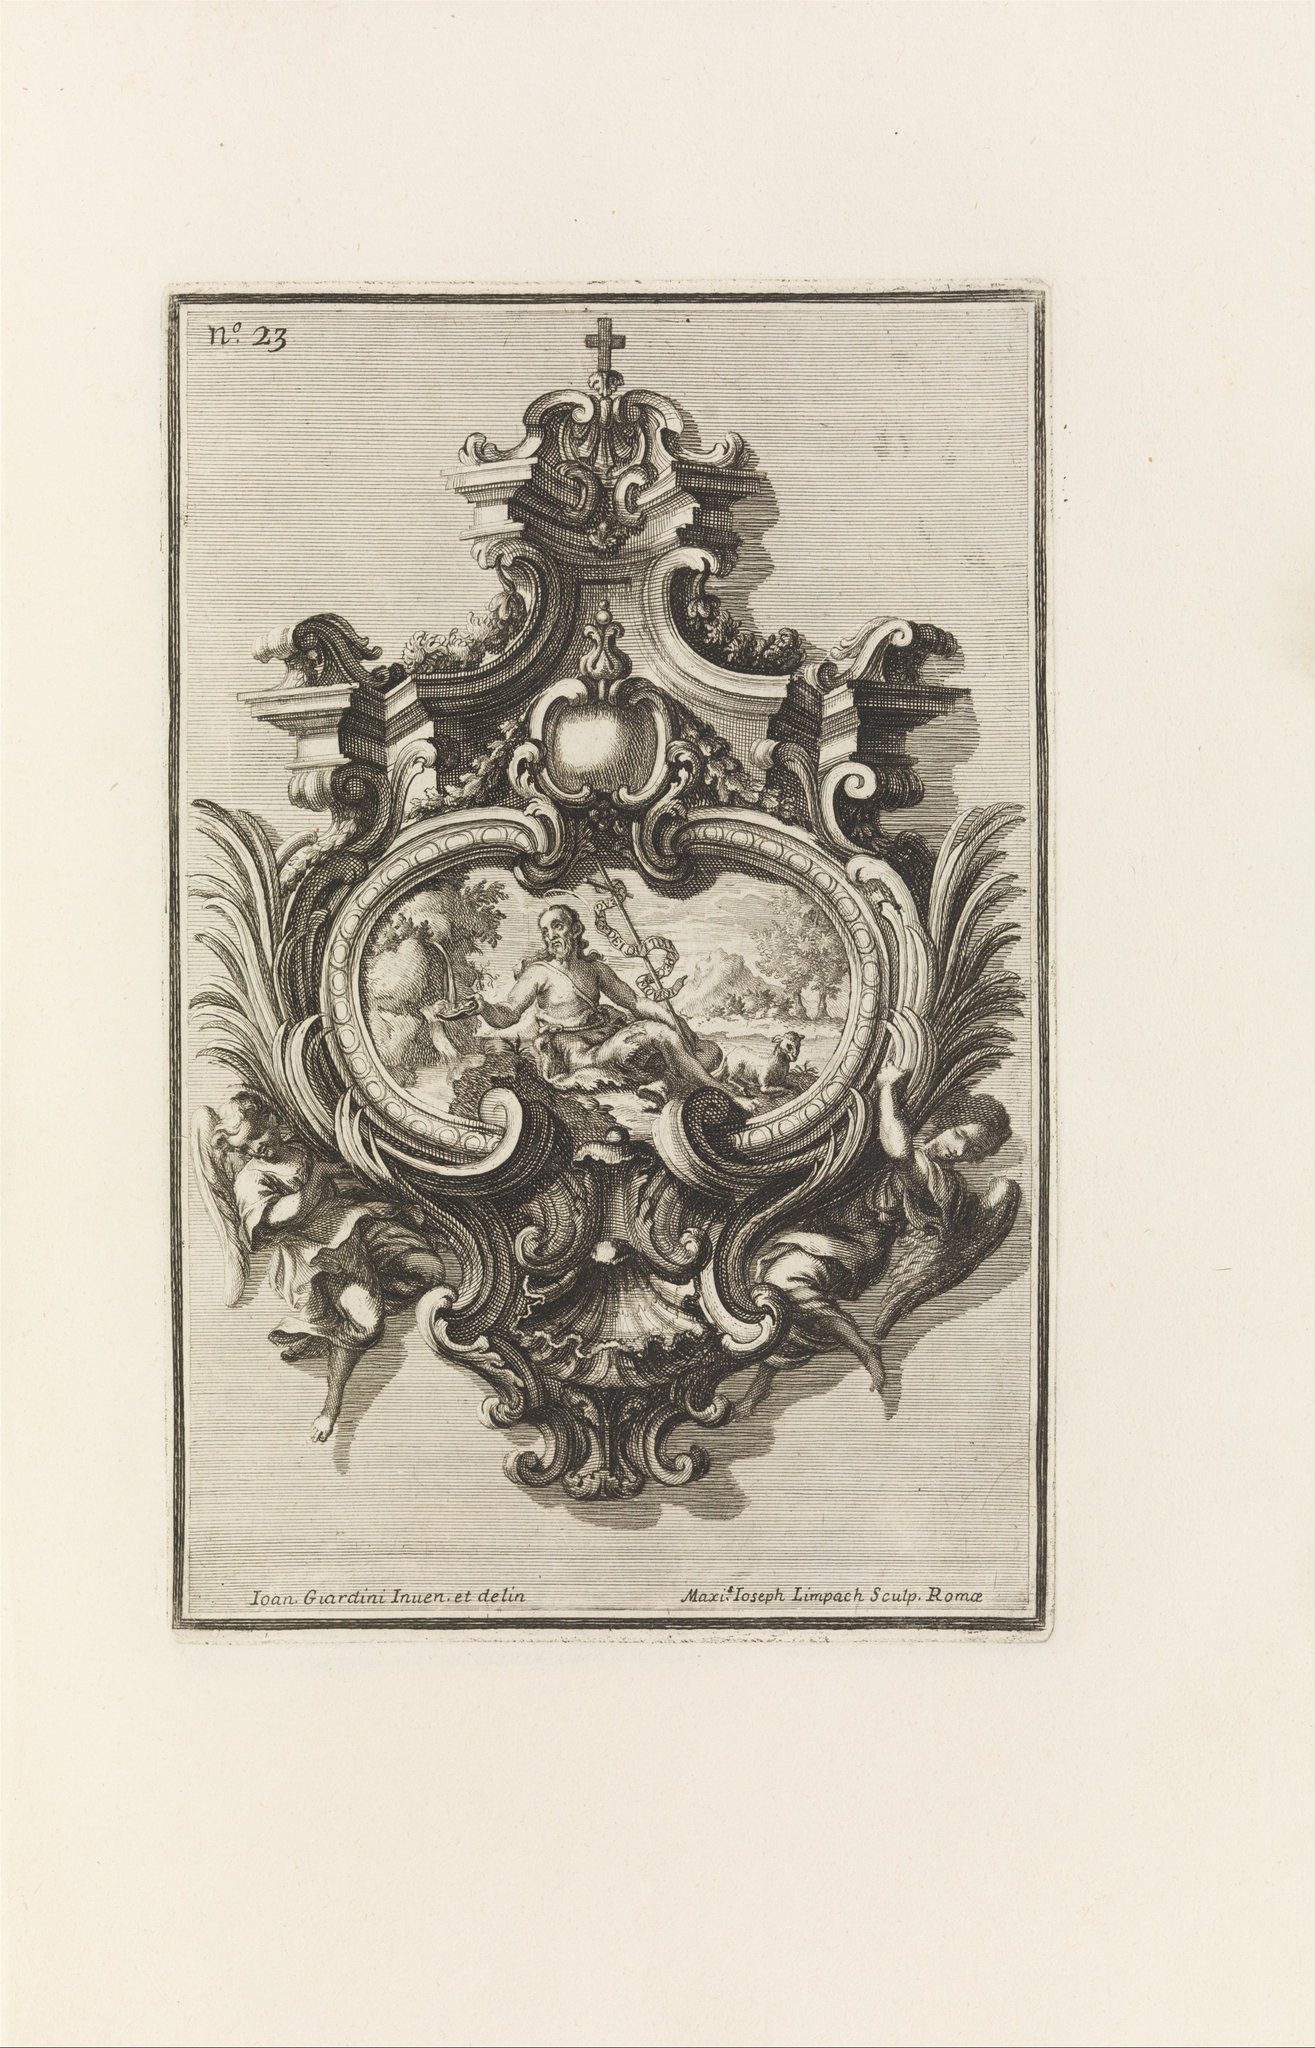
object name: book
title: Promptuarium Artis Argentariae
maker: giovanni giardini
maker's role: artist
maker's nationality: italian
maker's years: 1646-1722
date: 1750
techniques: etching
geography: italy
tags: men,leaves,angels,cross